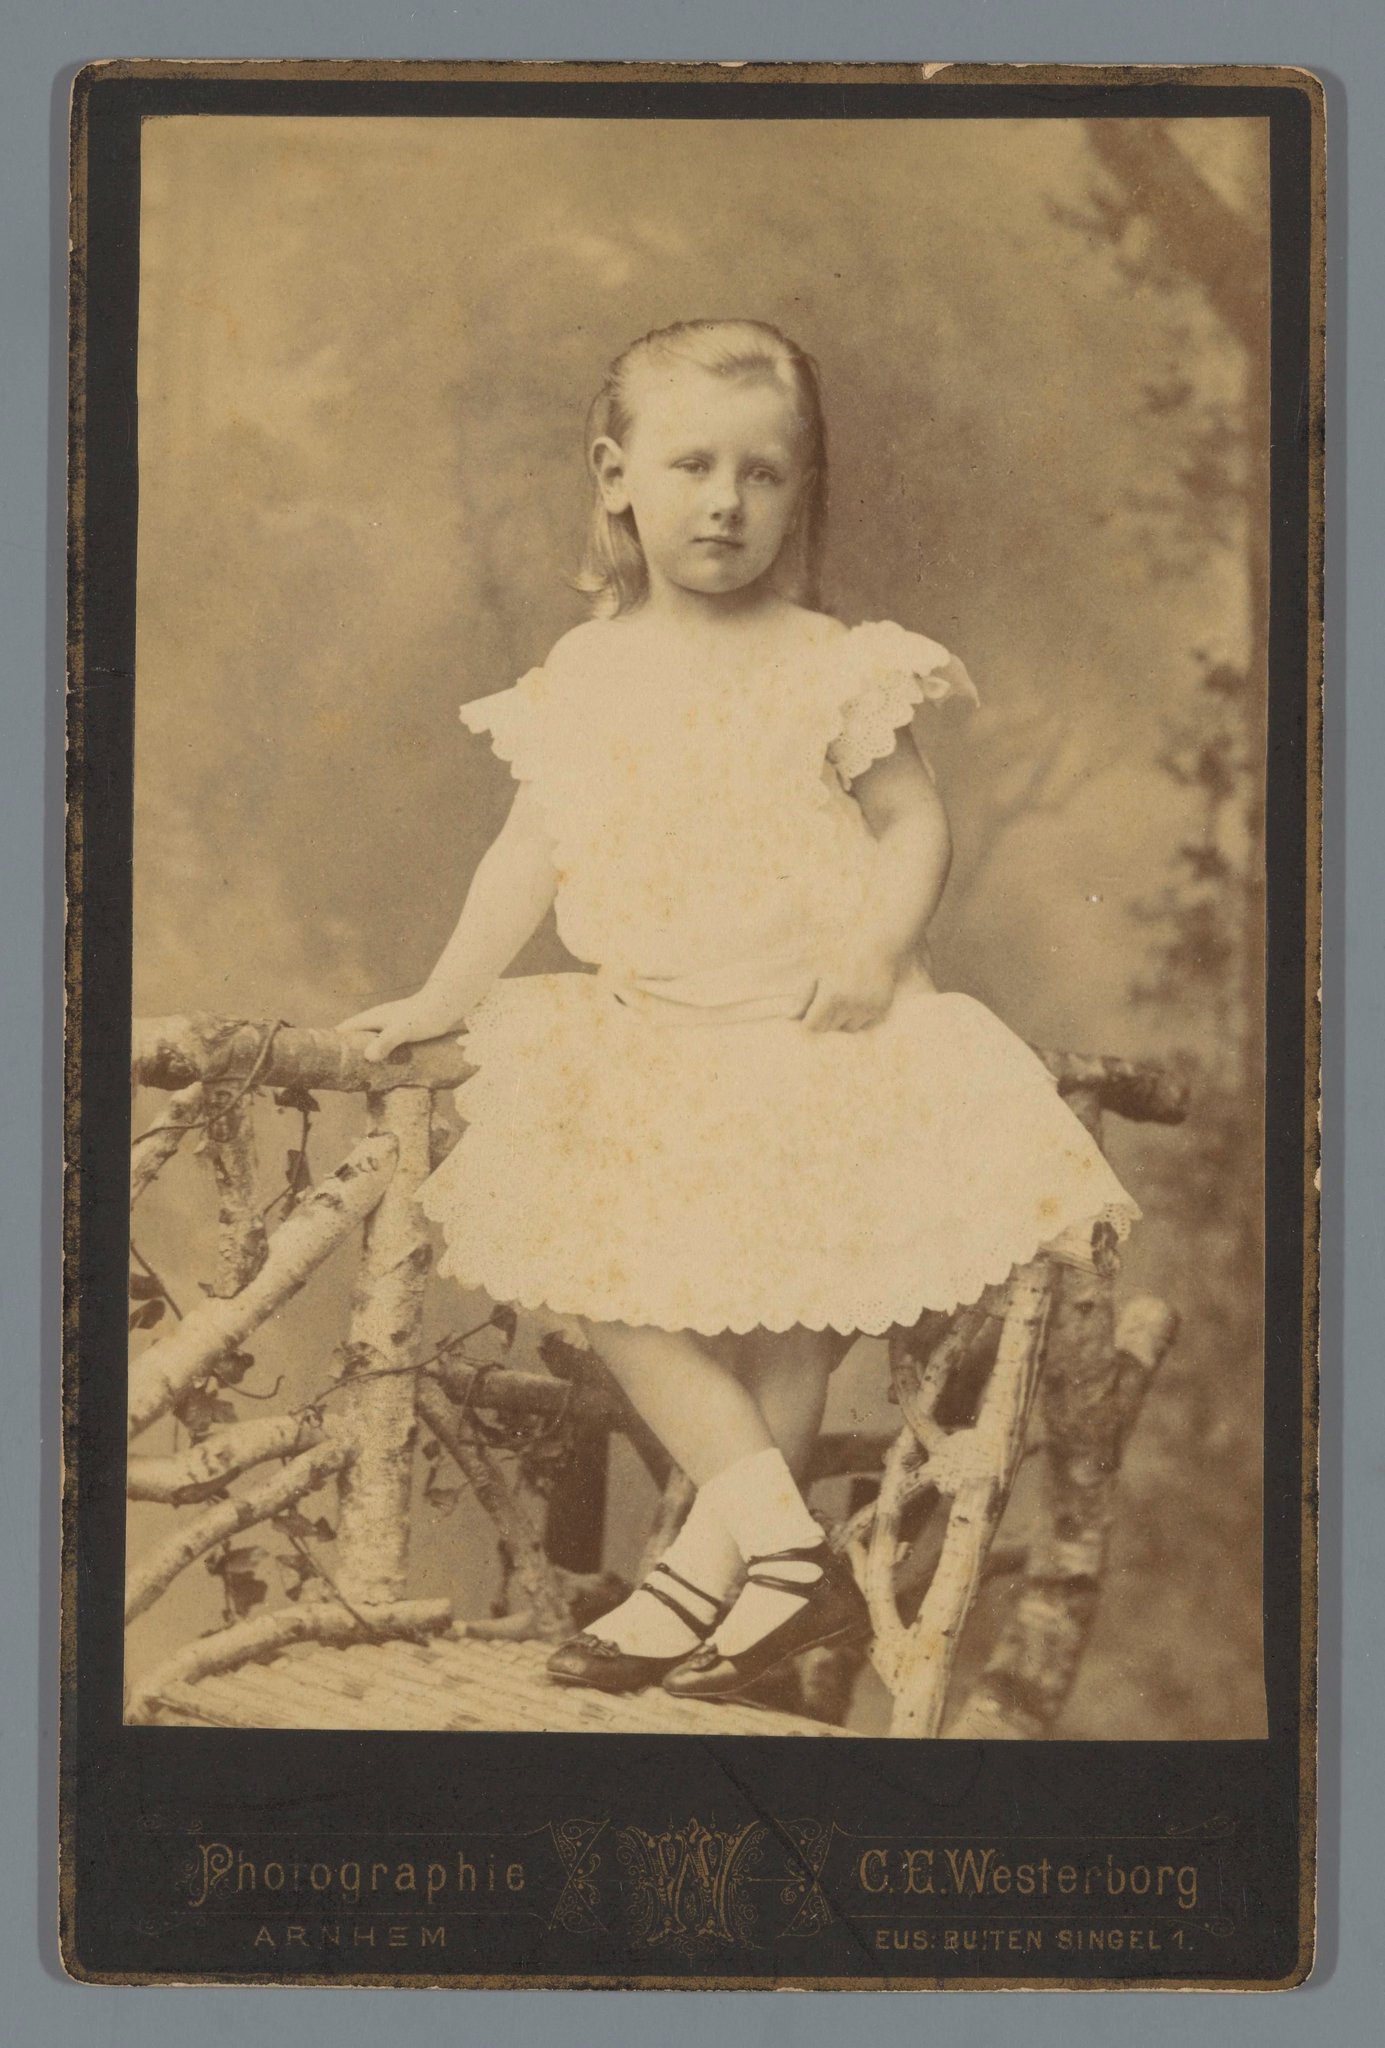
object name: cabinet photograph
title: Portret van prinses Wilhelmina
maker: carel eduard westerborg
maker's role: fotograaf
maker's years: 1842-1916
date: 1885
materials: cardboard, paper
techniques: albumen print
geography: arnhem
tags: print maker, wilhelmina of the netherlands, crown princess, historical persons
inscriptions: inscription: ‘koningin Wilhelmina/ 1885’, address: ‘EUS: BUITEN SINGEL 1.’